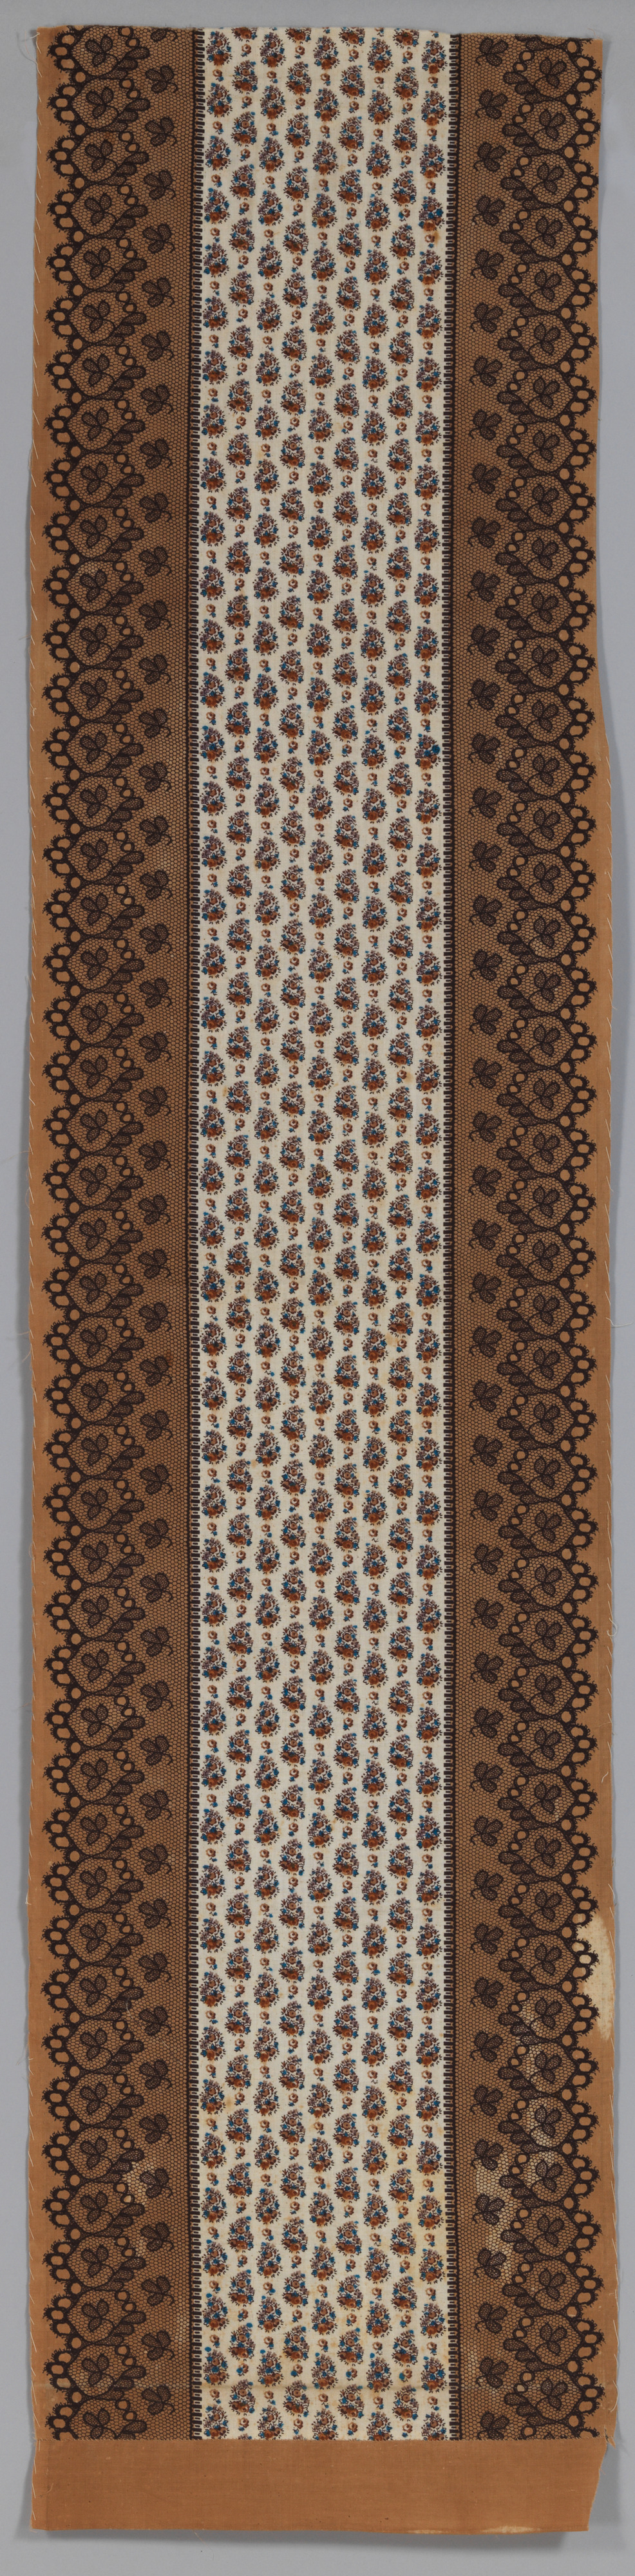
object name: piece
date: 1801-1900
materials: cotton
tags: leaves